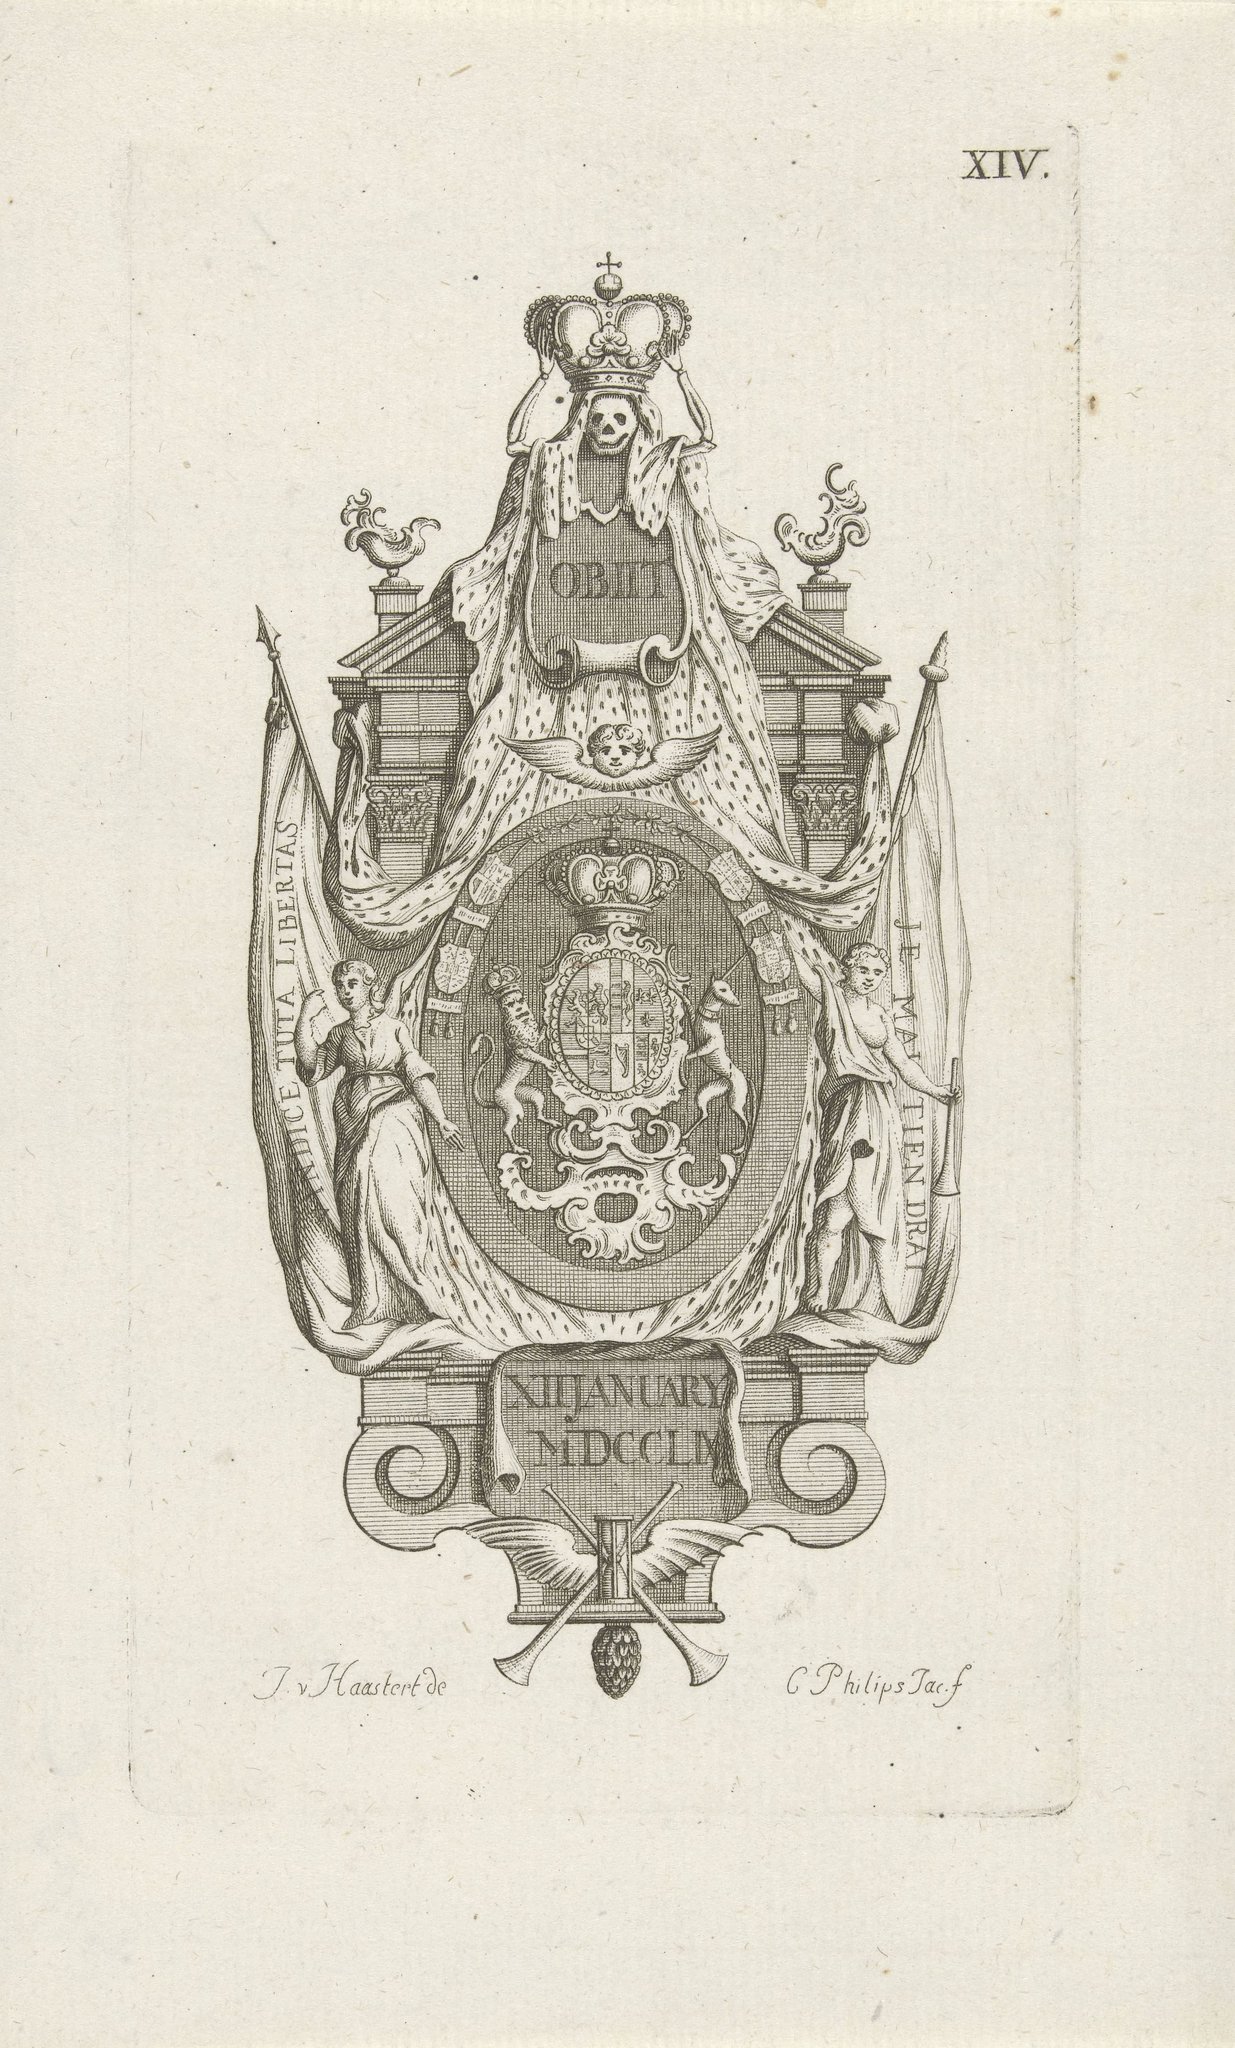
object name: print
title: Monument voor de overleden prinses Anna, 1759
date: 1765-1789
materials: paper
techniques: engraving, etching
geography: northern netherlands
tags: anna van hannover, grave, tomb and other grave-forms and grave-markers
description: Monument of gedenksteen voor de in 1759 overleden prinses Anna van Hannover. Monument opgebouwd uit vaandels, allegorische vrouwenfiguren en een koninklijke hermelijnen mantel, bekroond door een skelet met koningskroon. Centraal het wapen van de prinses vastgehouden door een leeuw en een eenhoorn. Rechtsboven gemerkt: XIV.